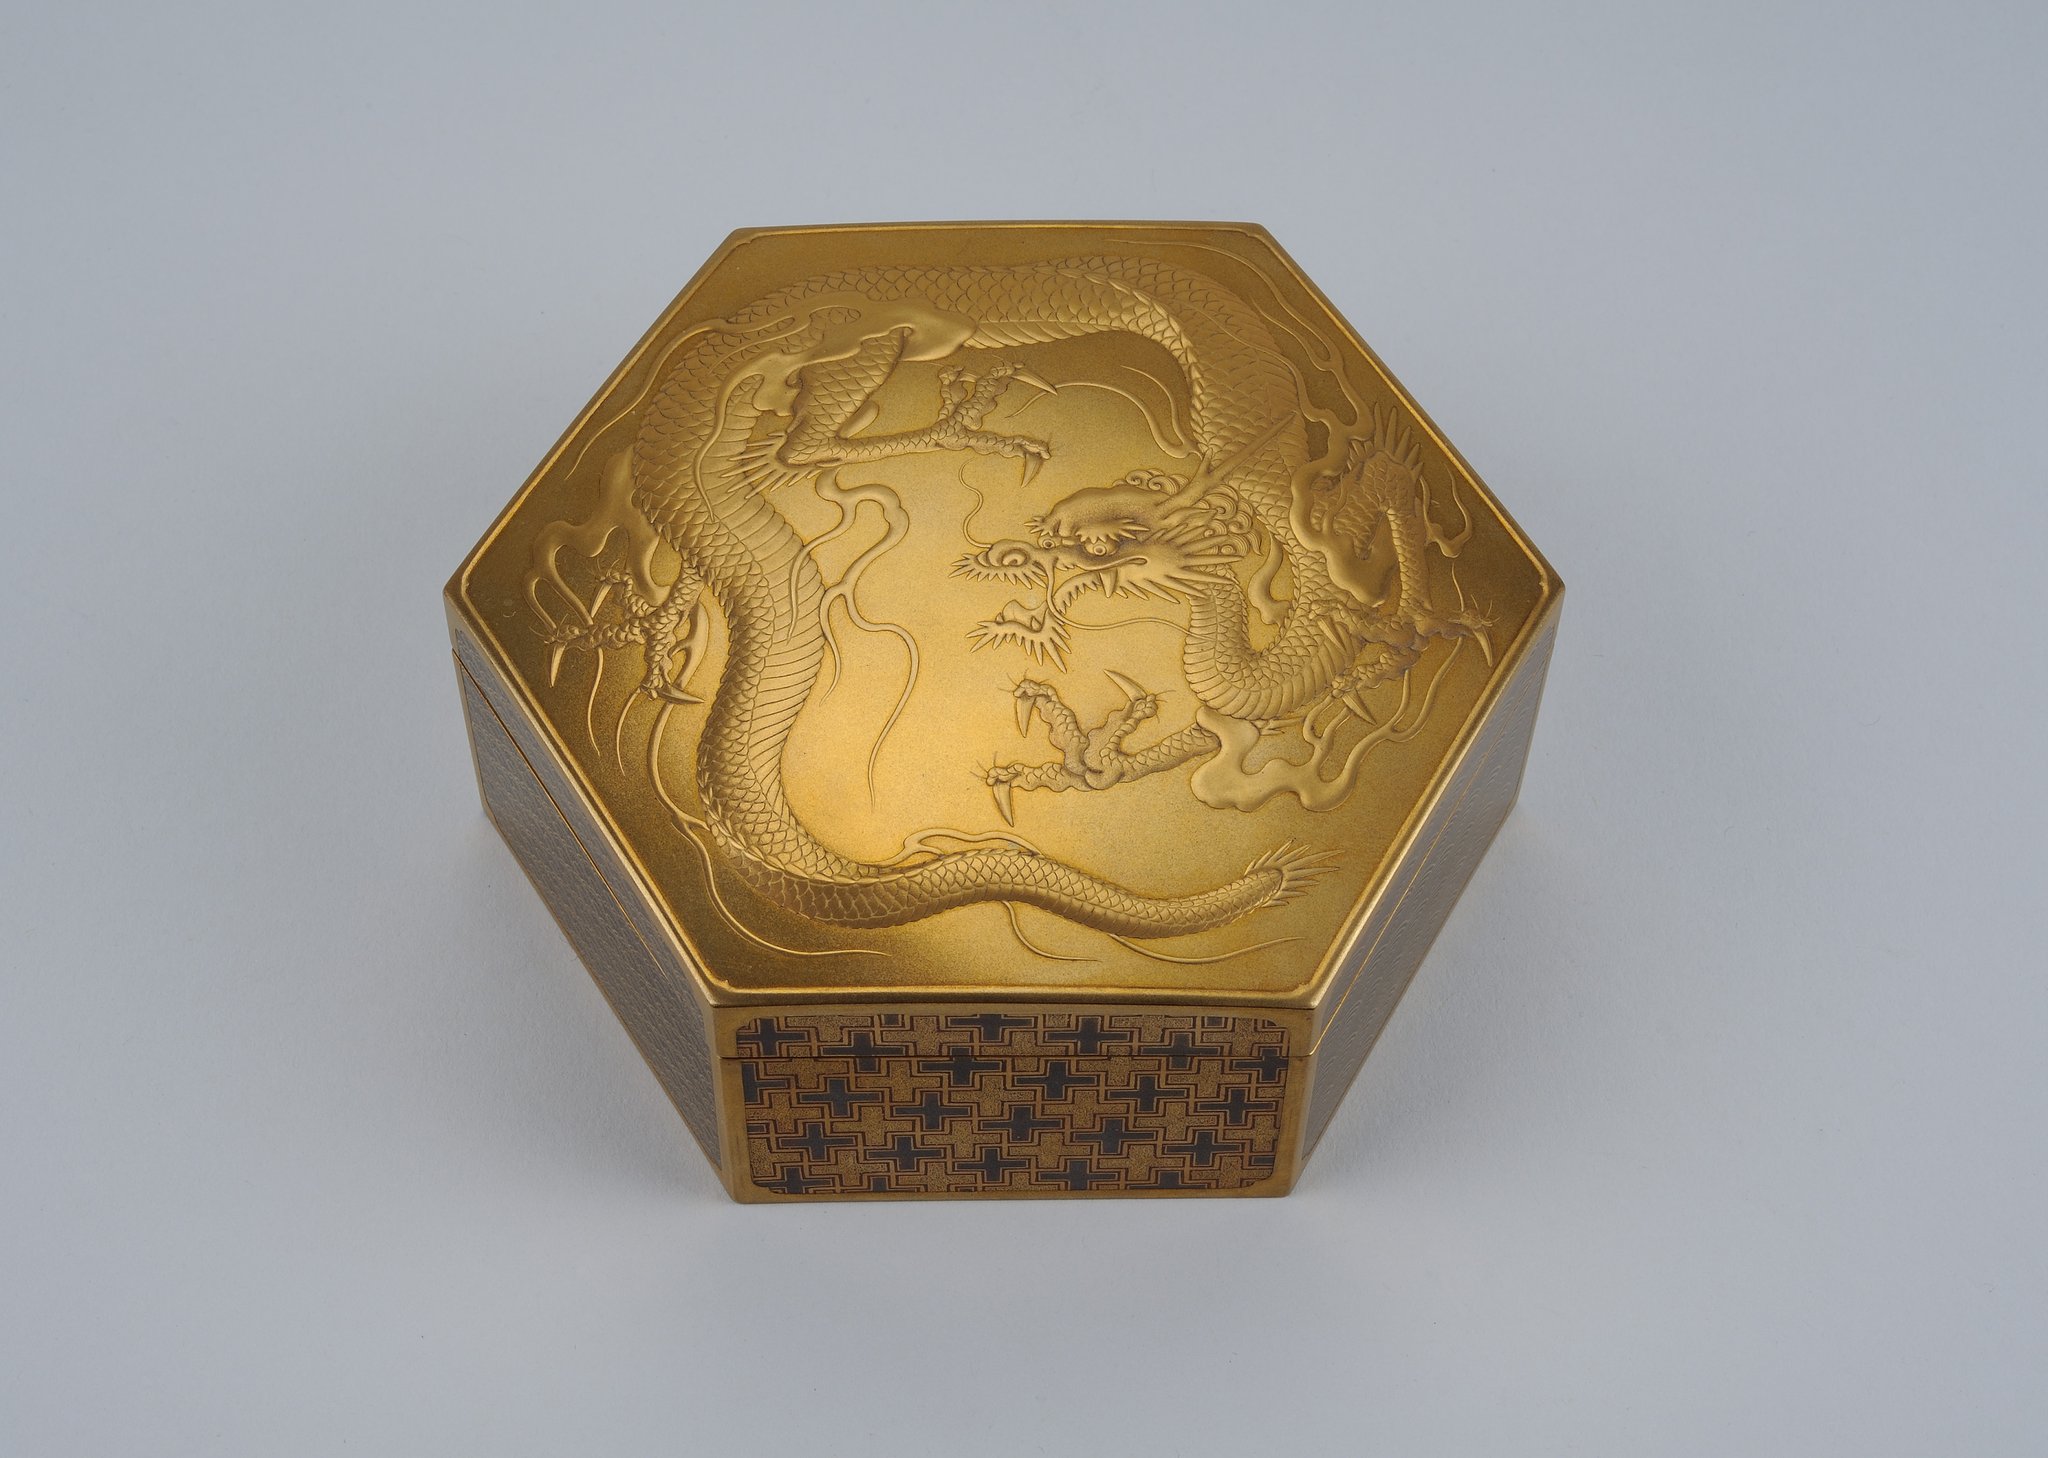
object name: kobako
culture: japanese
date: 1701-1800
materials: gold, lacquer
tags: dragons